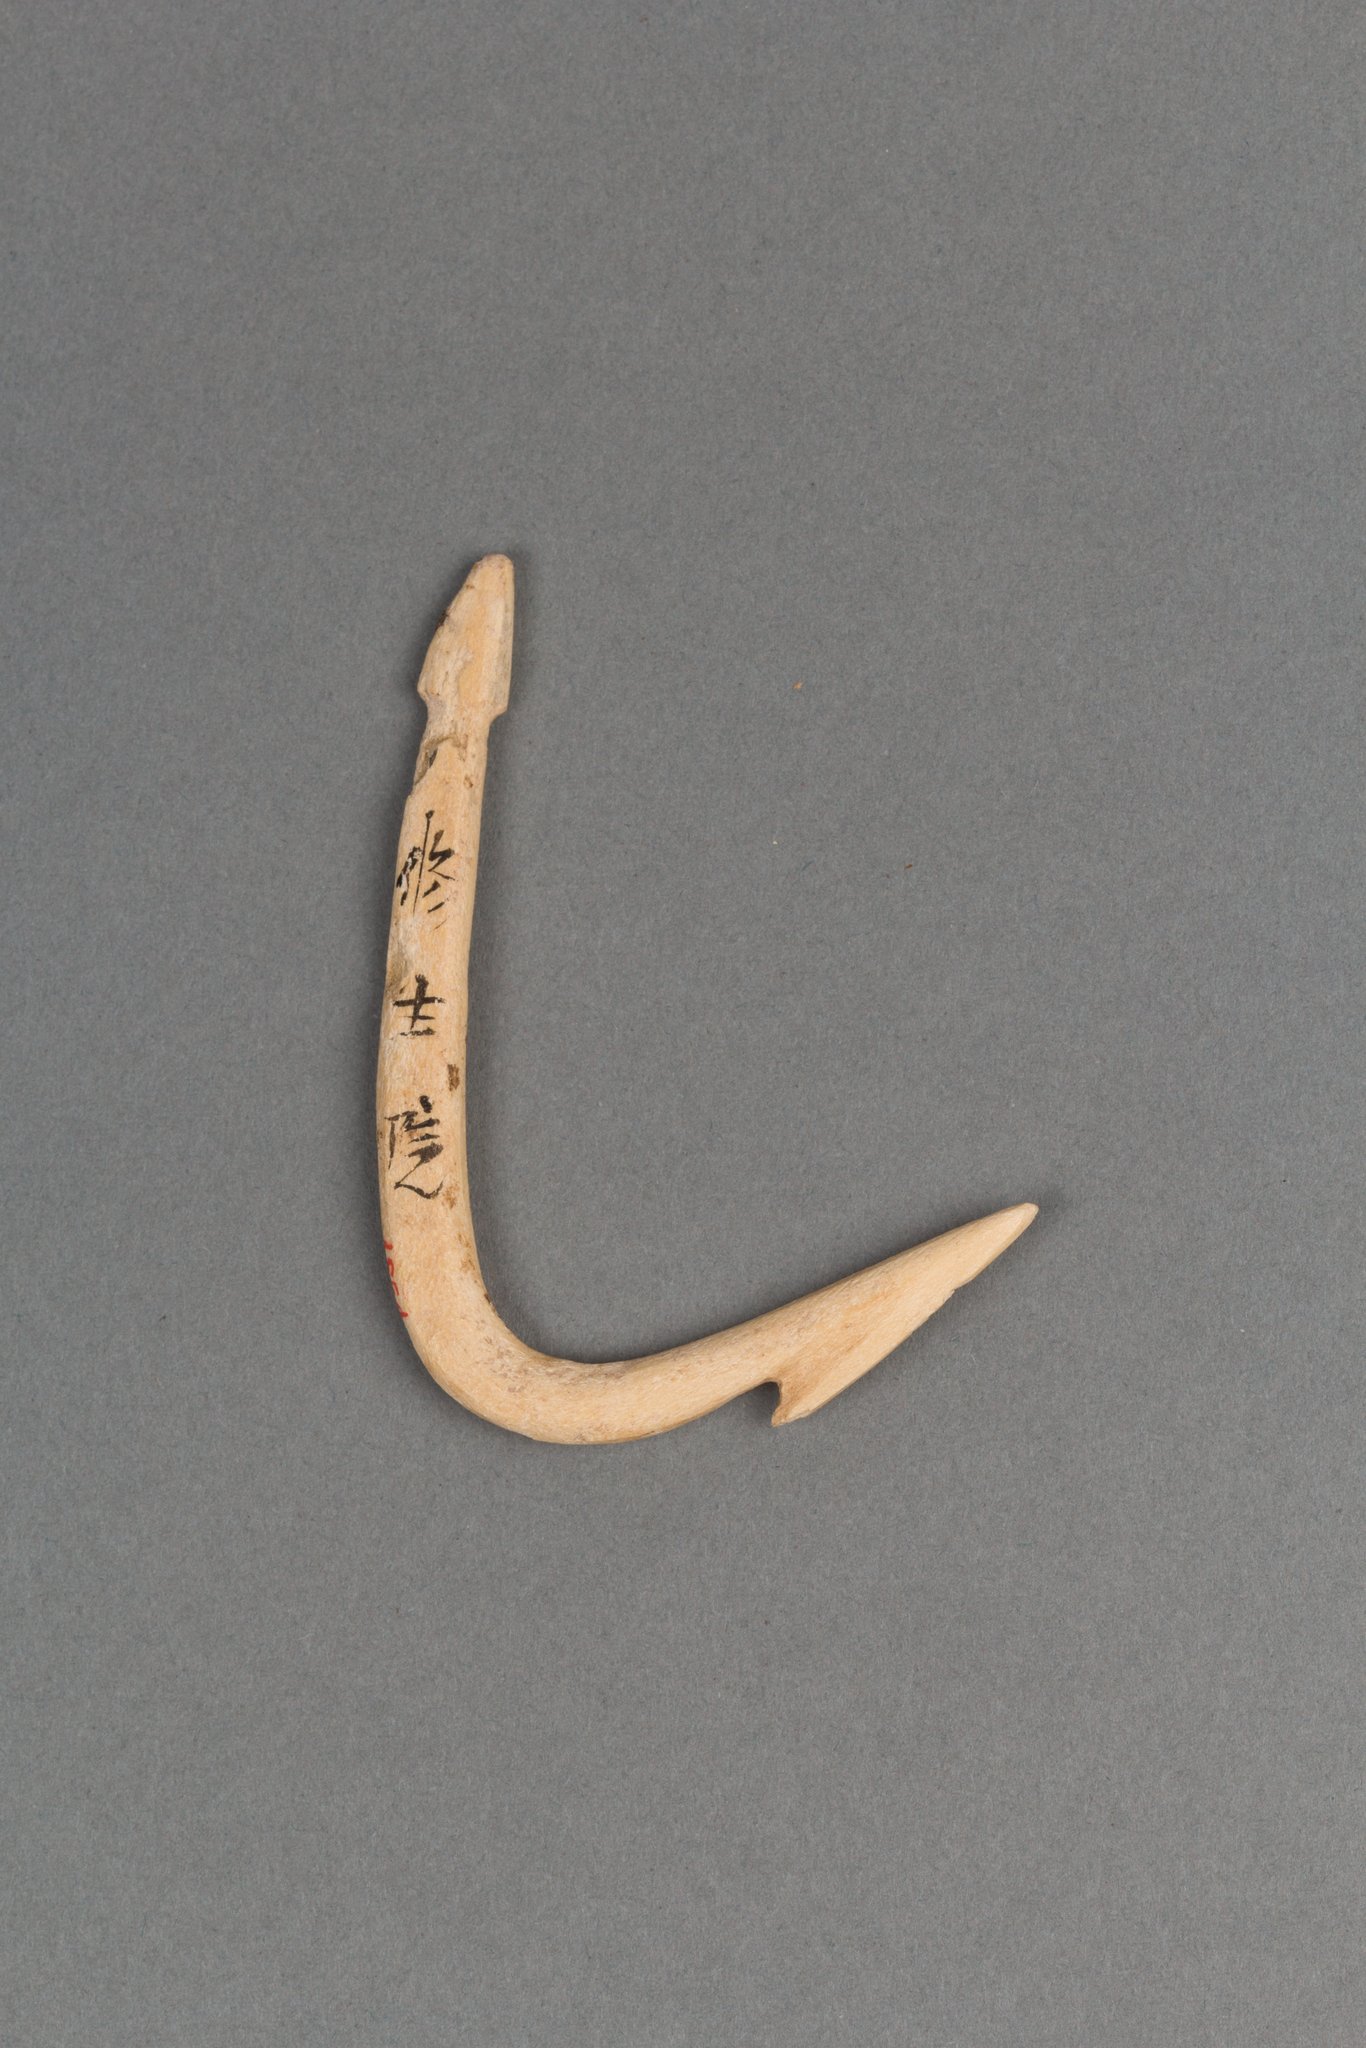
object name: fish hook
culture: japanese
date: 1000-300 BCE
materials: bone